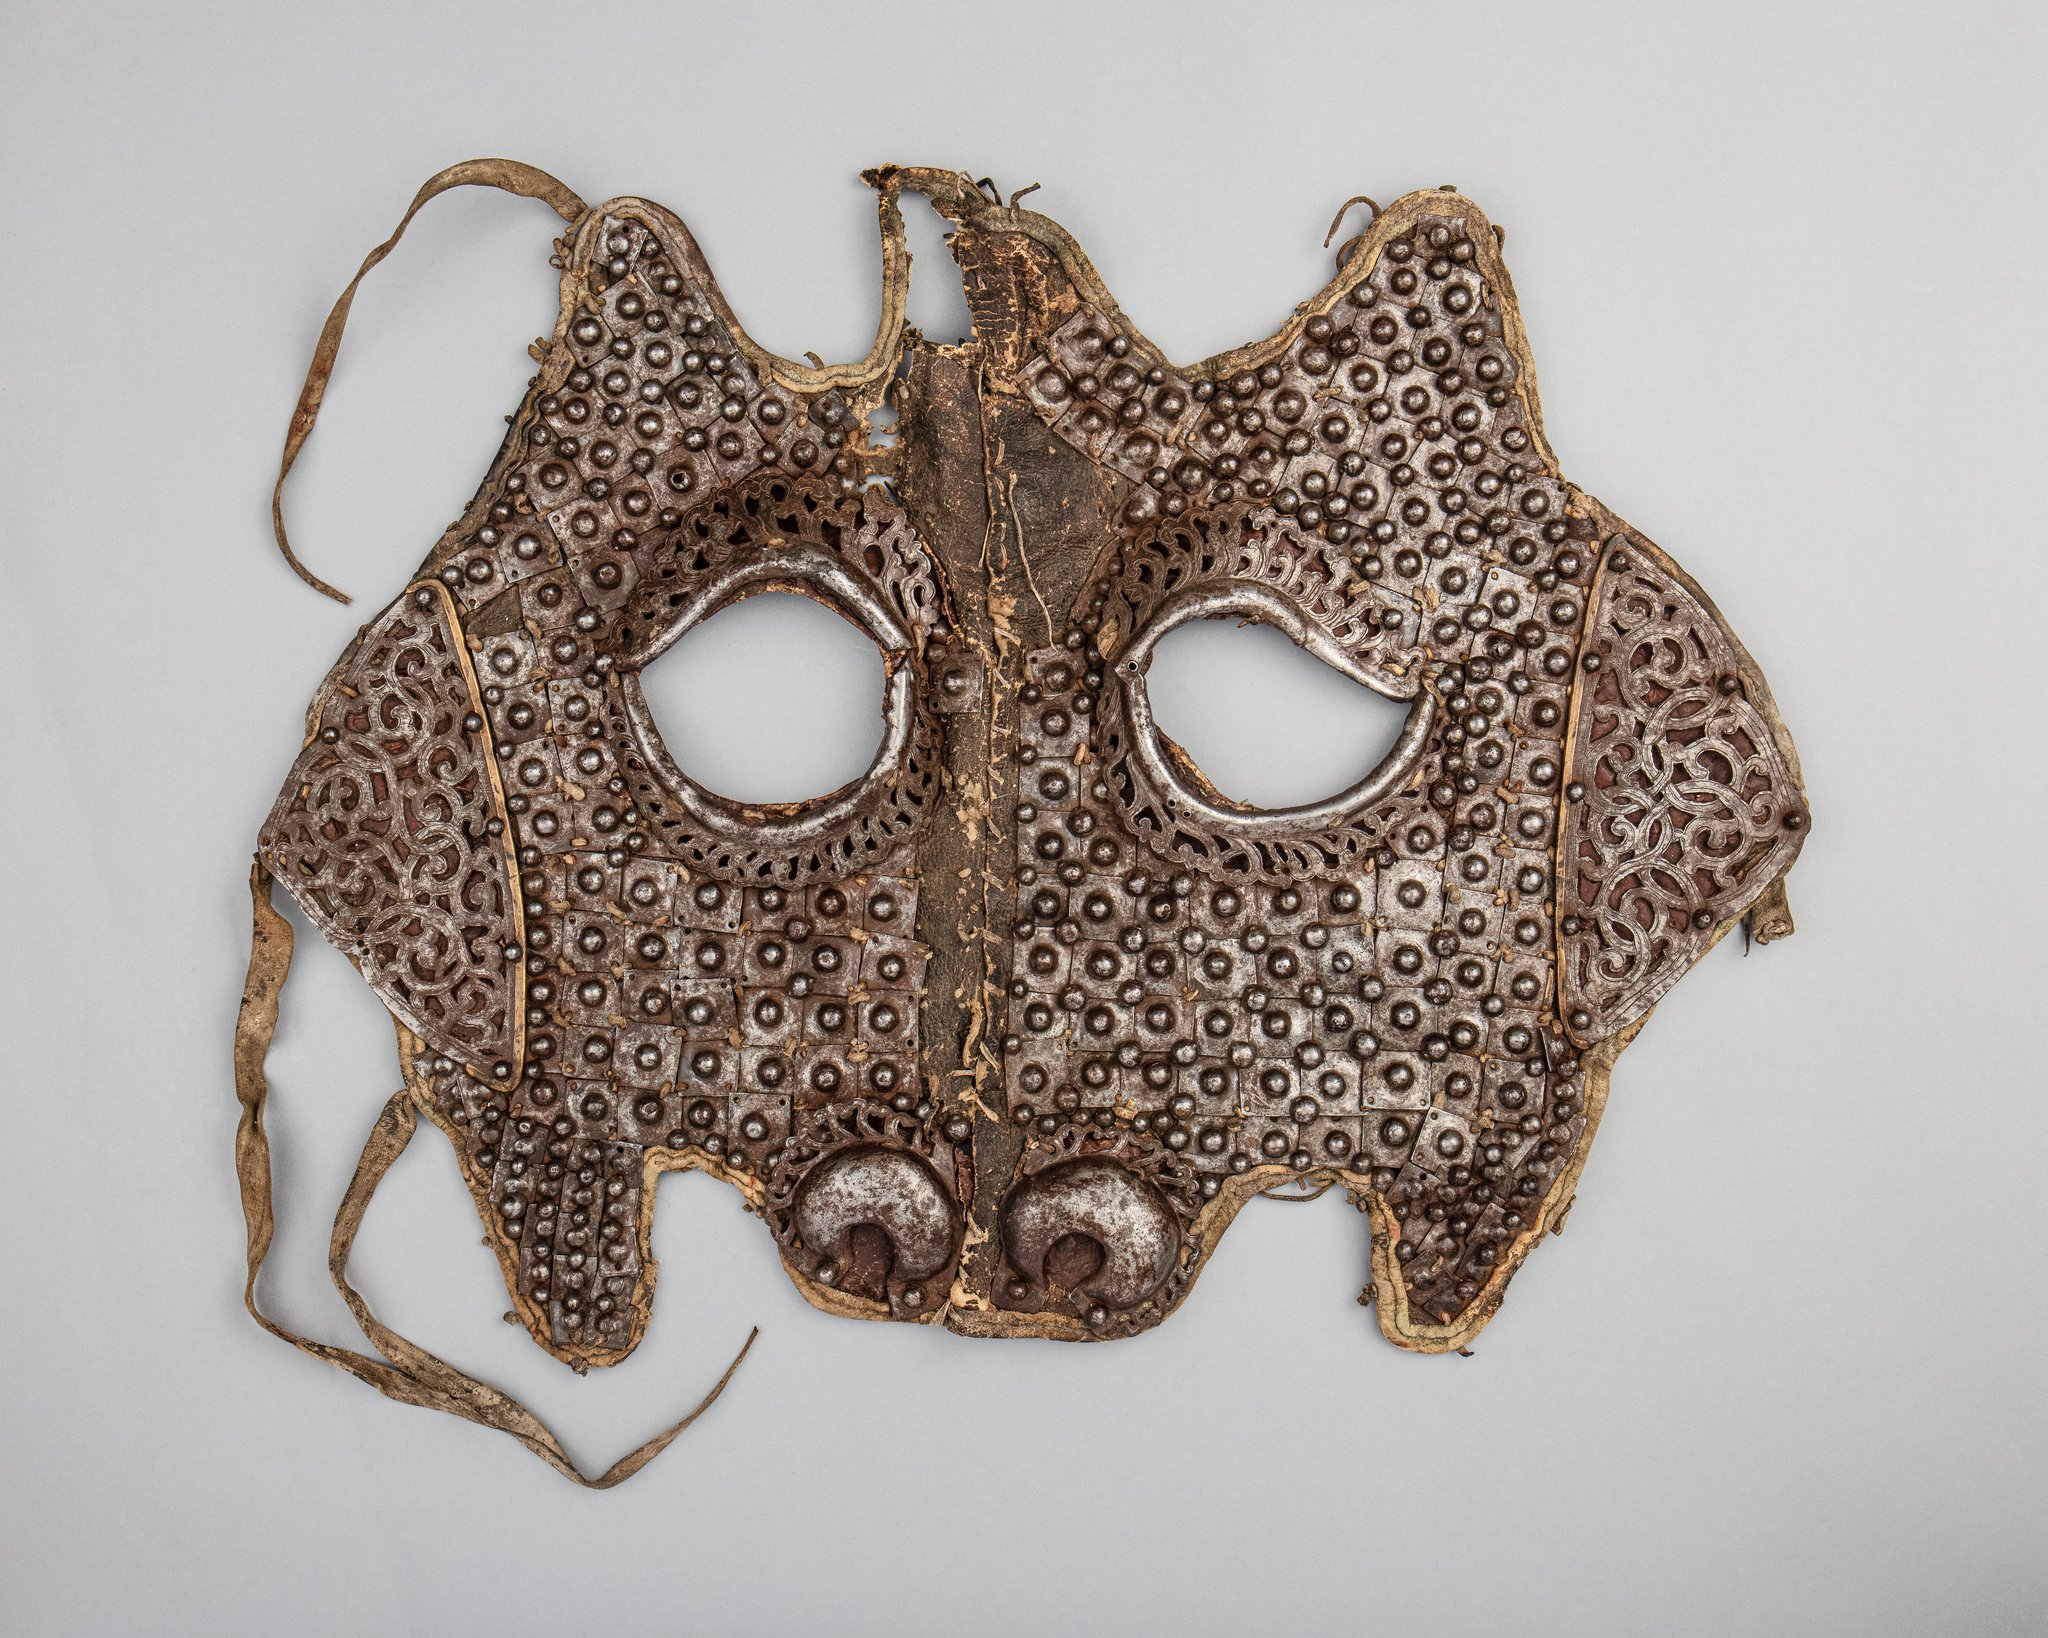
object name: shaffron horse's head defense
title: Shaffron (Horse's Head Defense)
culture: mongolian or tibetan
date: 1501-1700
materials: copper alloy, iron, leather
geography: tibet